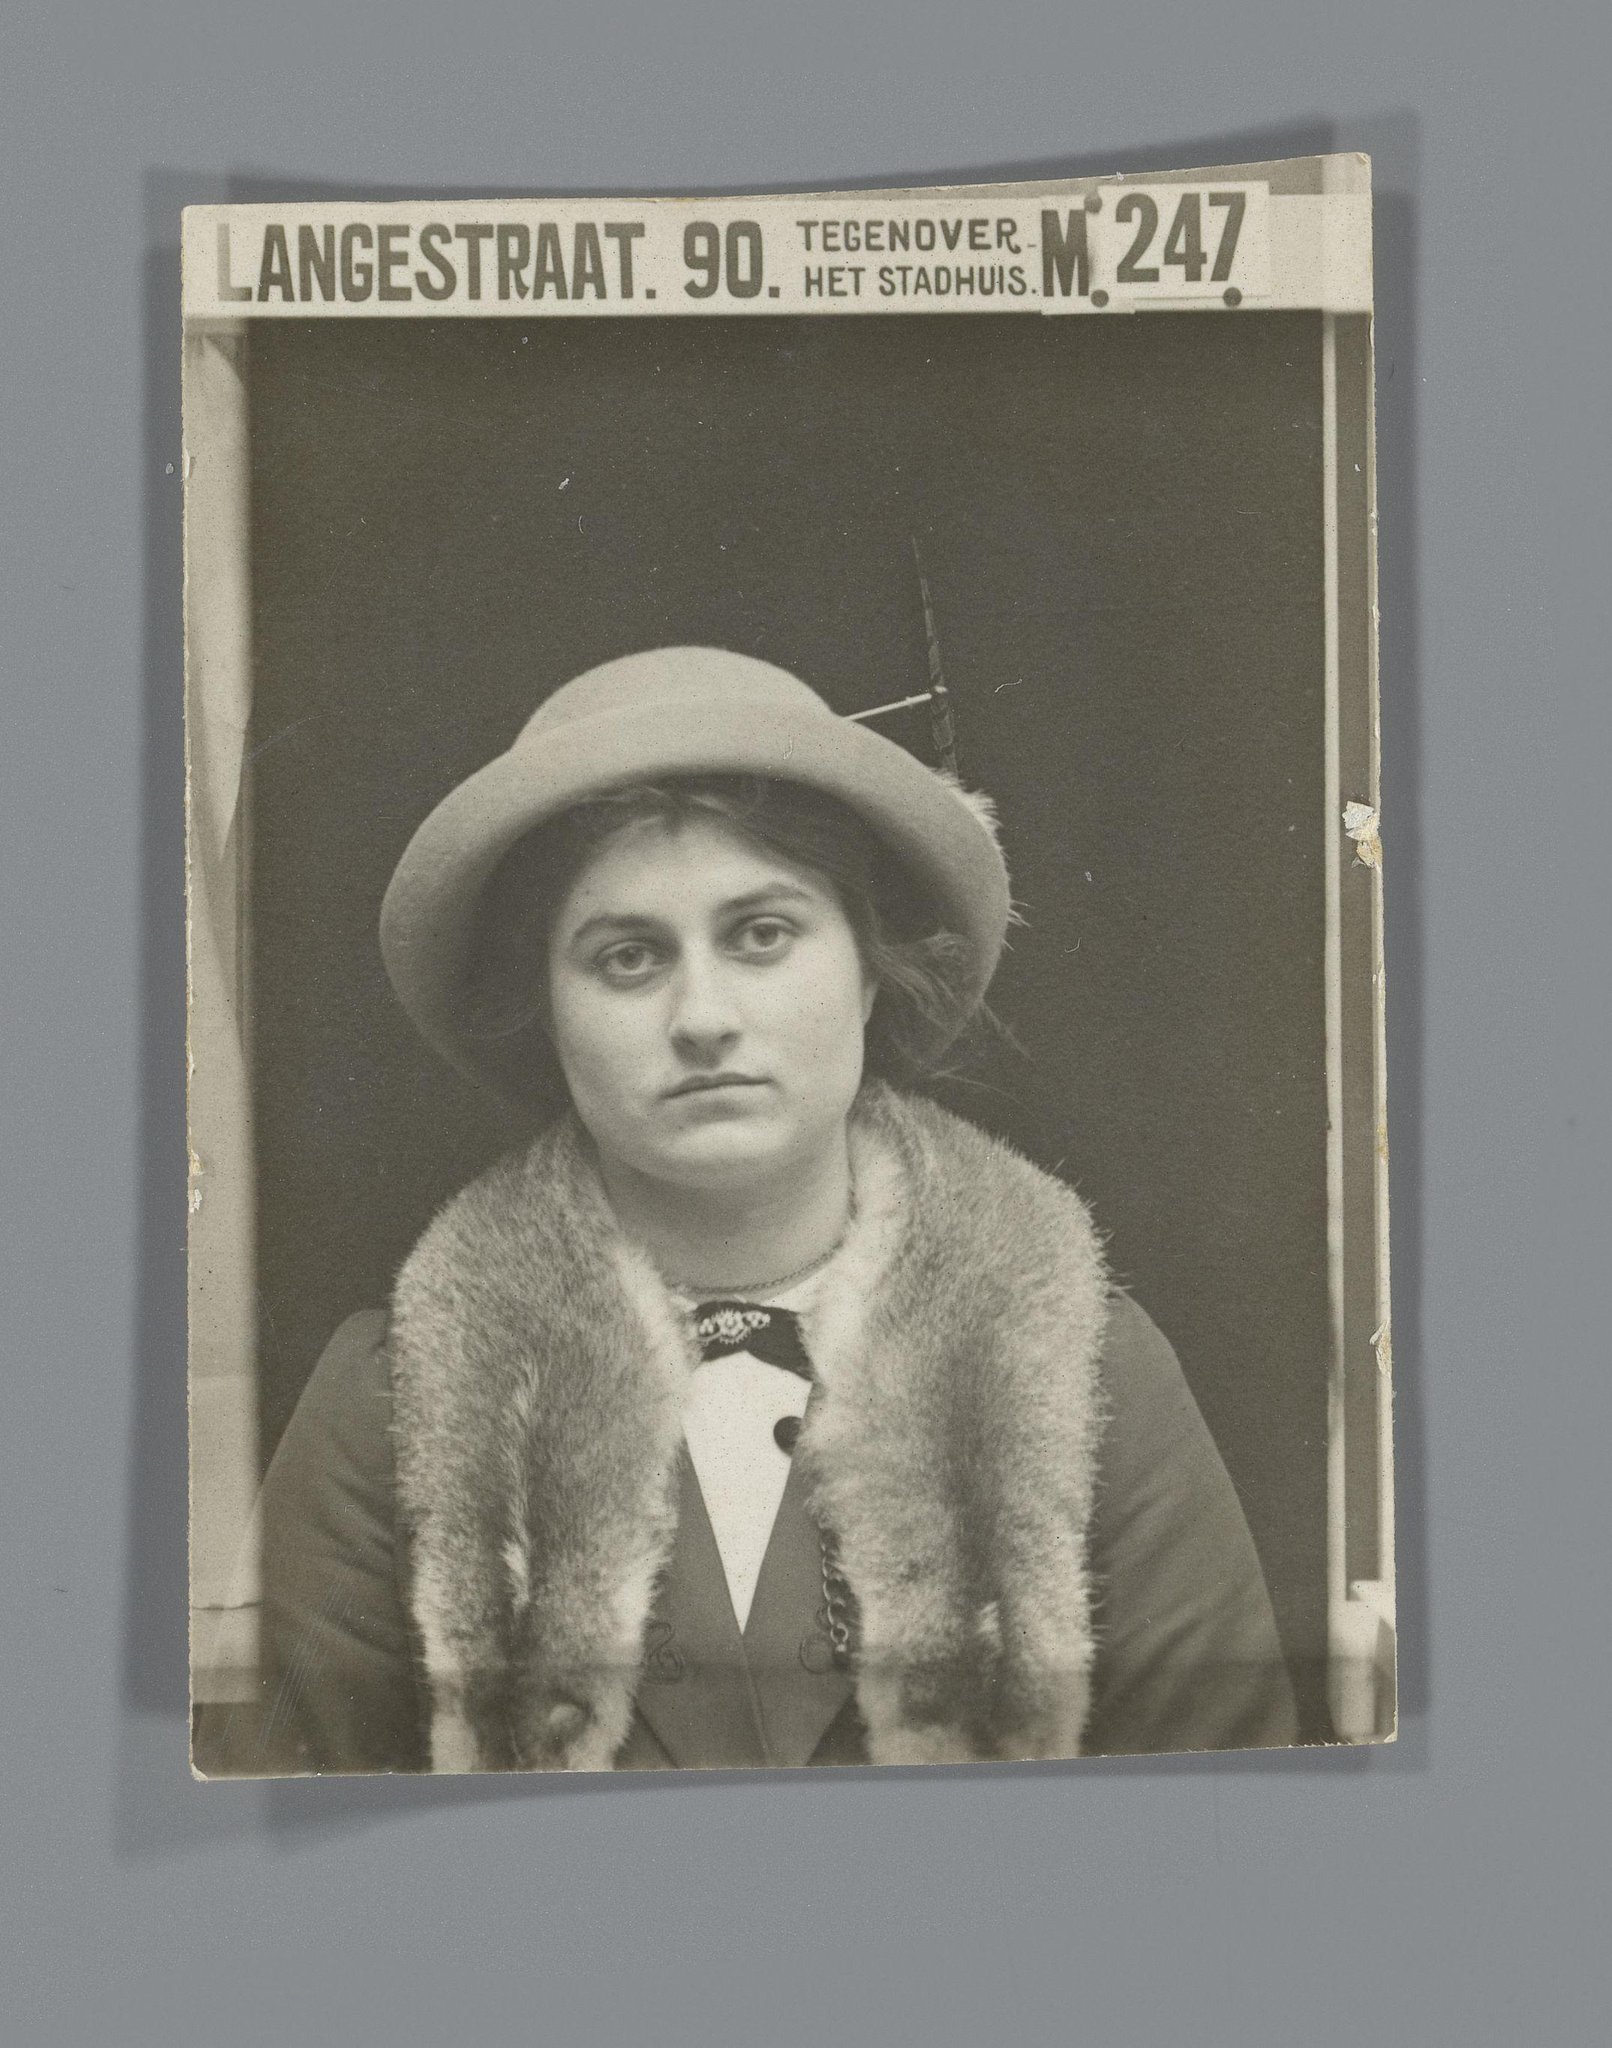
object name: snapshot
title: Rapid photographs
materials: photographic support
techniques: gelatin silver print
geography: alkmaar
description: Between 1912 and 1930, anyone could have their portrait taken at the many so-called rapid photography studios in the shopping streets of mainly (medium) large-size European cities. As if on an assembly line, the youngest clerk shot the photographs with a special camera and in artificial light and developed them. Later in the day, the customer collected a sheet with 12 portrait photos for 25 cents. This form of photographic mass production gave rise to a fascinating tableau of boys, girls, men and women not previously seen in photographs; candid and informal. There were at least 150 quick-photo studios, from Alkmaar to Zutphen. Many called themselves ‘American,’ mistakenly as it turns out because hardly any examples from that country have been found.